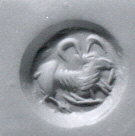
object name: stamp seal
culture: sasanian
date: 401-700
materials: stone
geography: iran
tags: animals